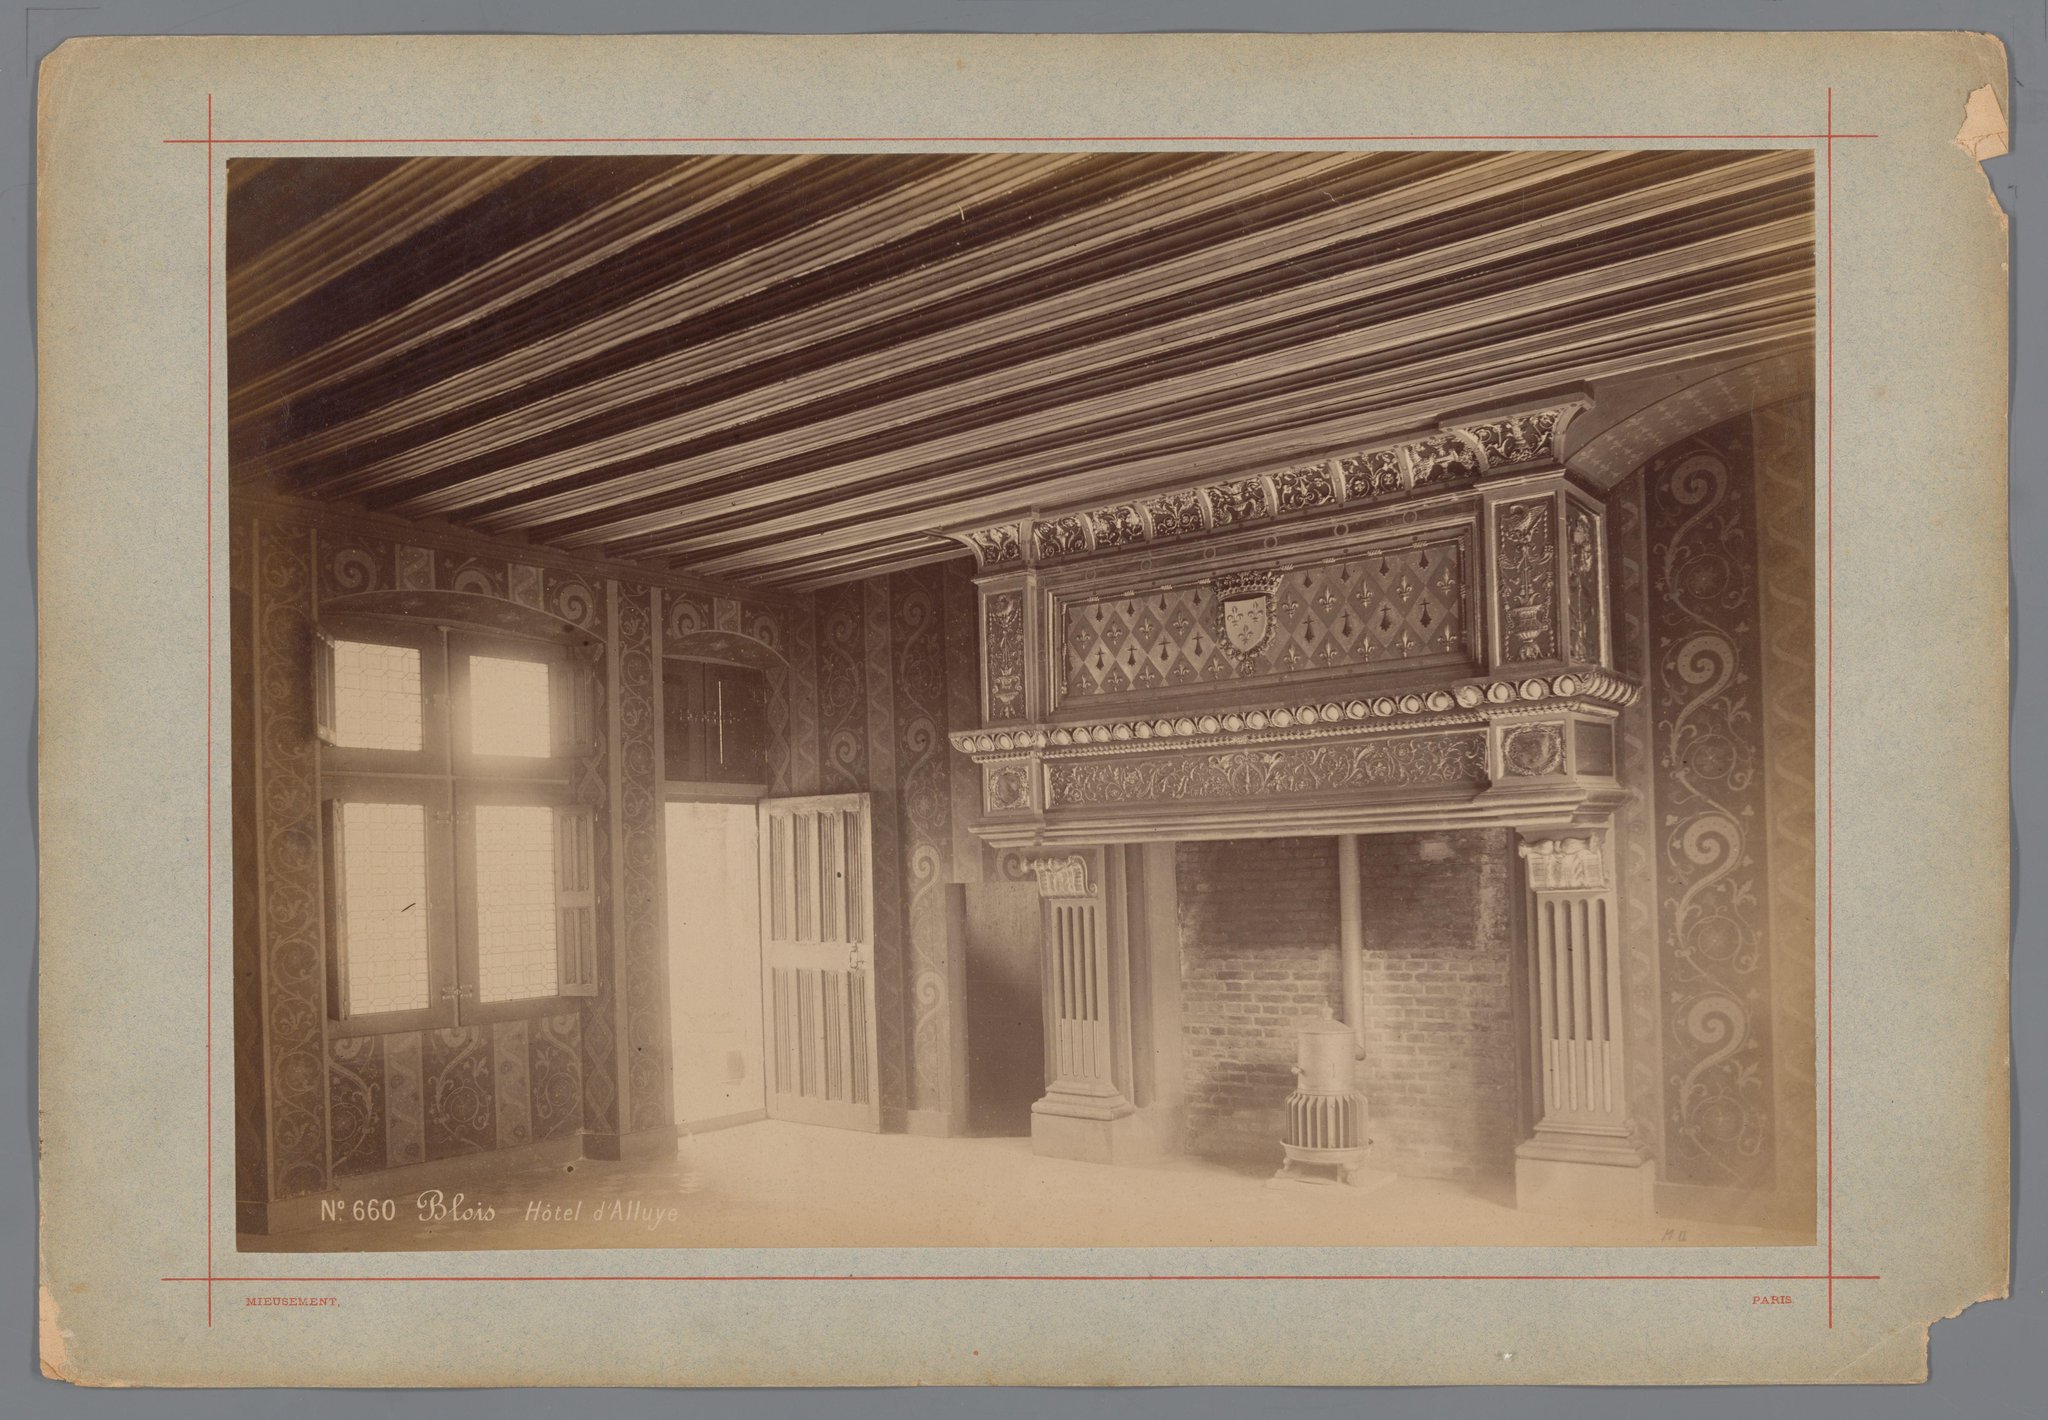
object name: photograph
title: Interieur met een schouw in Hôtel d'Alluye te Blois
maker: séraphin-médéric mieusement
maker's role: fotograaf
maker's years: 1840-1905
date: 1875-1900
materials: cardboard, photographic support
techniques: albumen print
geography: blois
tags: tendrils ~ ornament - aa - stylized, open hearth, fire-place, interior ~ representation of a building, hôtel, i.e. small palace in city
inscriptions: name: ‘MIEUSEMENT, PARIS’, name: ‘MIEUSEMENT PHOTOGRAPHE’, inscription: ‘pl 12’, number: ‘No. 660’, inscription: ‘MONUMENTS HISTORIQUES’, name: ‘Monsters worden door de Representant J. A. G. de LEUR-den haag op franco aanvrage verzonden’, collector's mark: Lugt 3937